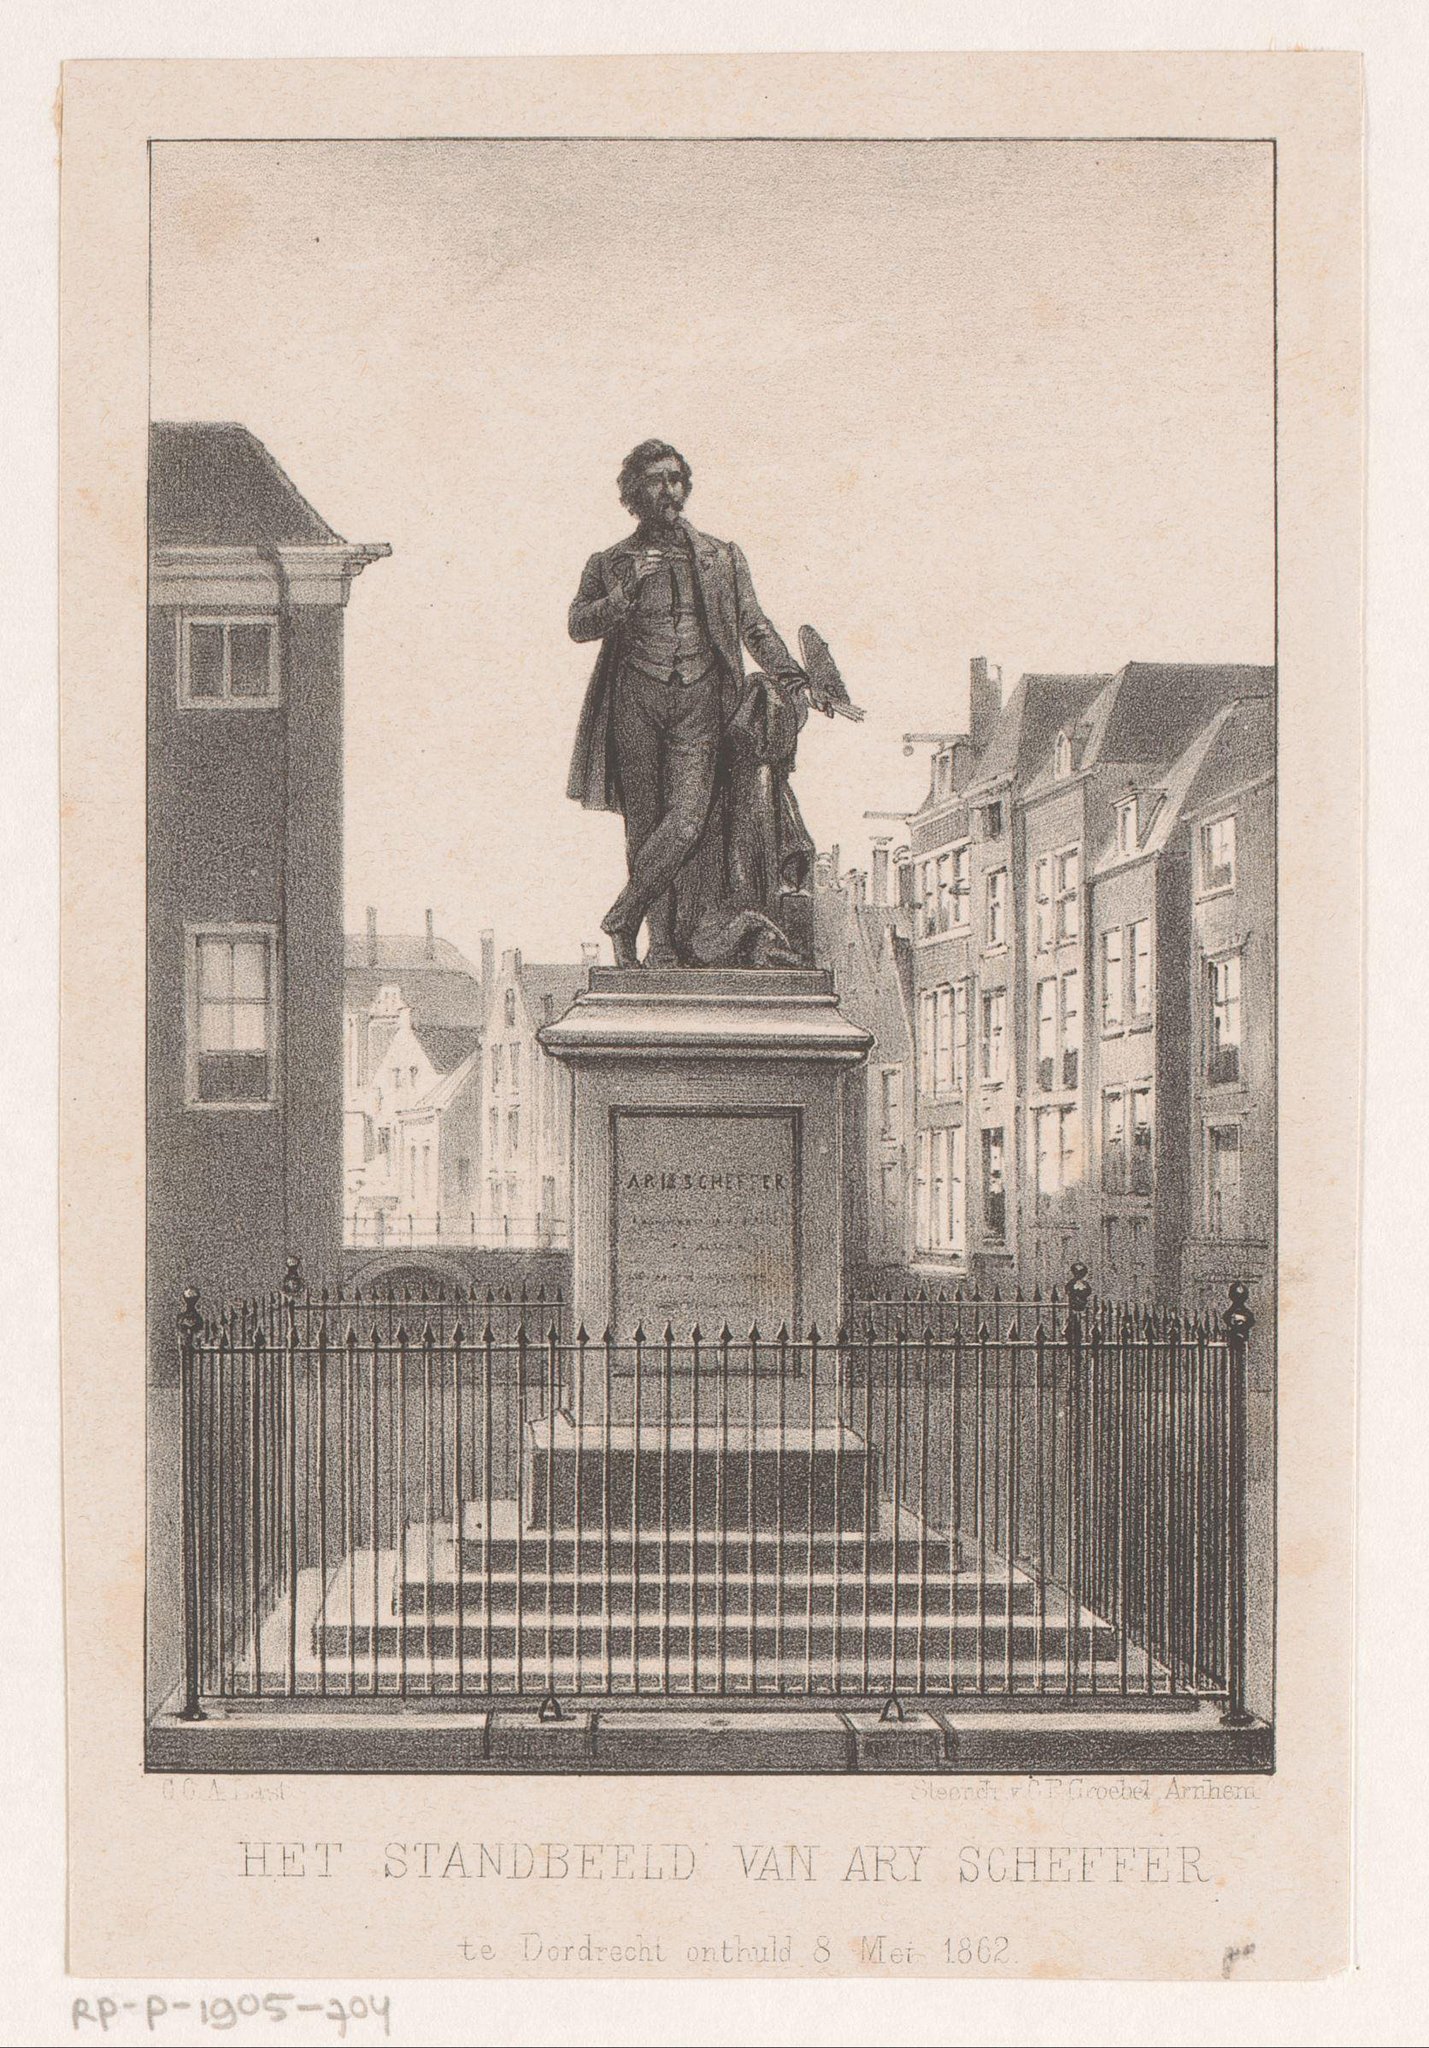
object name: print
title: Standbeeld van Ary Scheffer in Dordrecht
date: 1862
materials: paper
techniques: lithograph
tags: dordrecht, painter, print maker, draughtsman, sculptor, ary scheffer, piece of sculpture, reproduction of a piece of sculpture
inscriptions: collector's mark: Lugt 2228